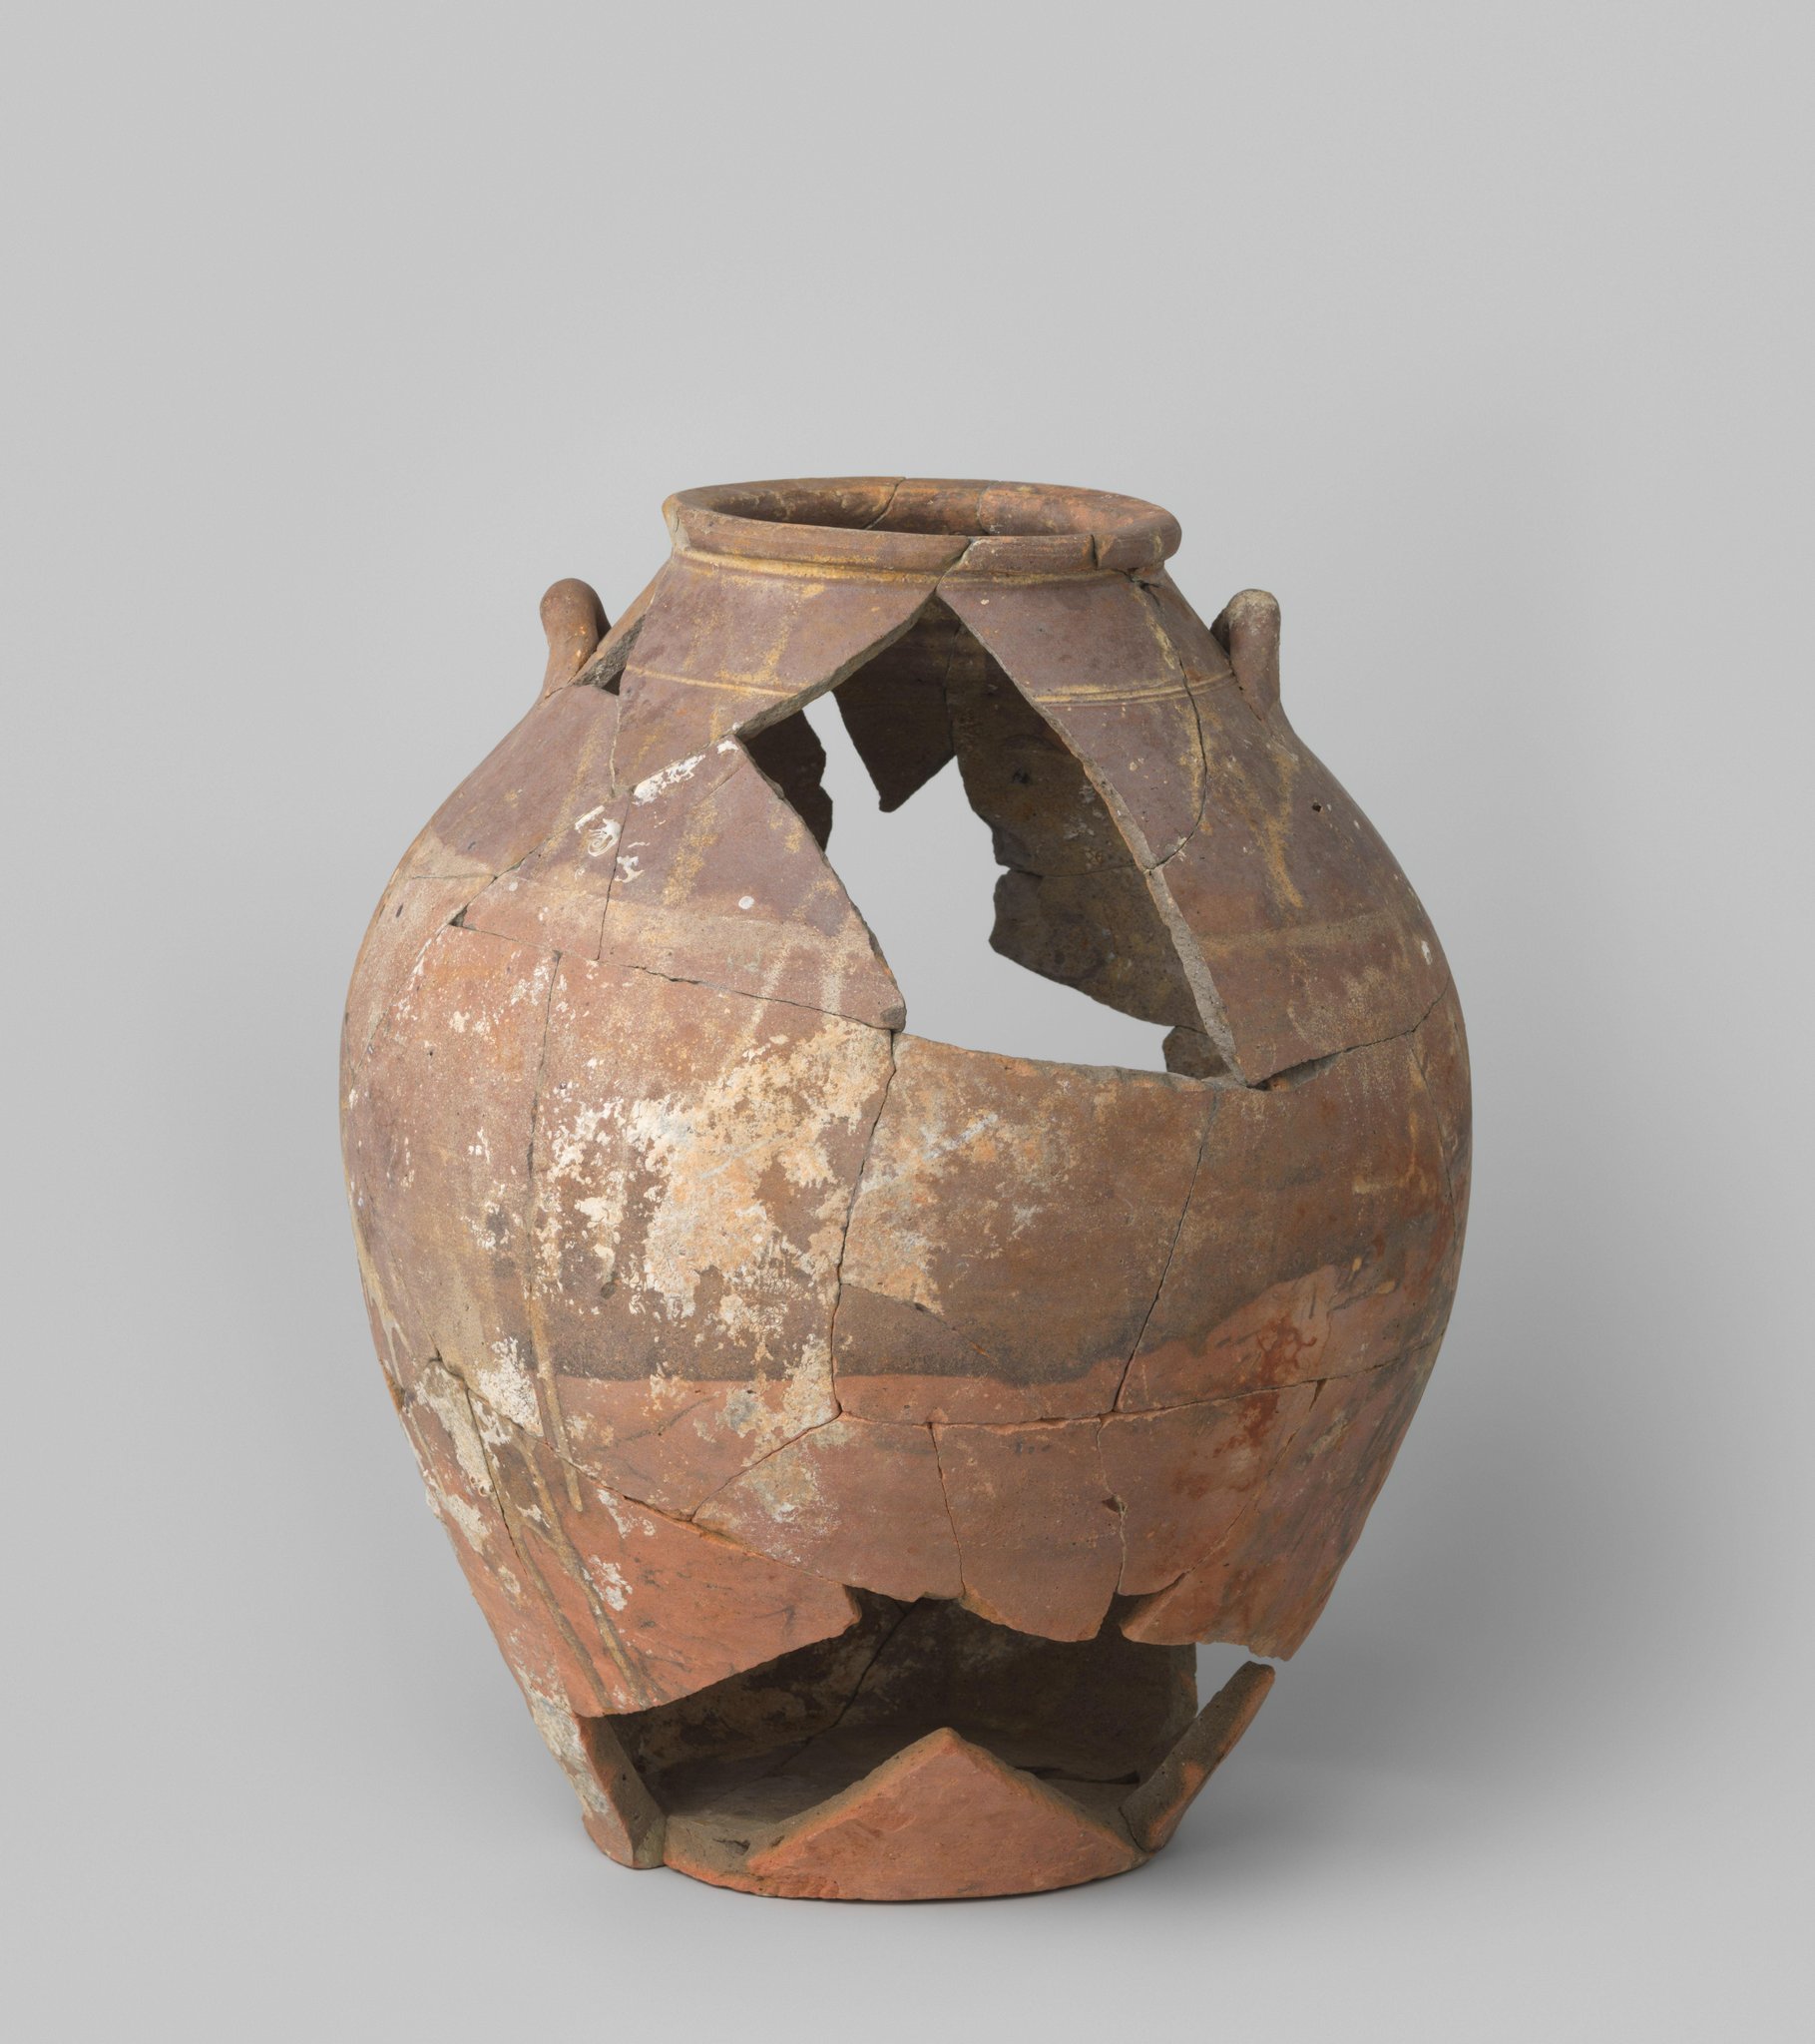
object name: vessel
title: Martavaan uit V.O.C.-schip de 'Witte Leeuw'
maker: Anonymous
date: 1613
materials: porcelain, stoneware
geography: sawankhalok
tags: verenigde oostindische compagnie, sint-helena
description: A jar. The body runs smoothly over in the neck which has an everted, flattened lip. The roughly finished base is slightly concave. The grey clay has black and white impurities. The inside of the upper half of the jar has yellow and grey discolourations, which could possibly be a slip. The ears are situated on a horizontal incised band. Between two ears this band has been double sided.